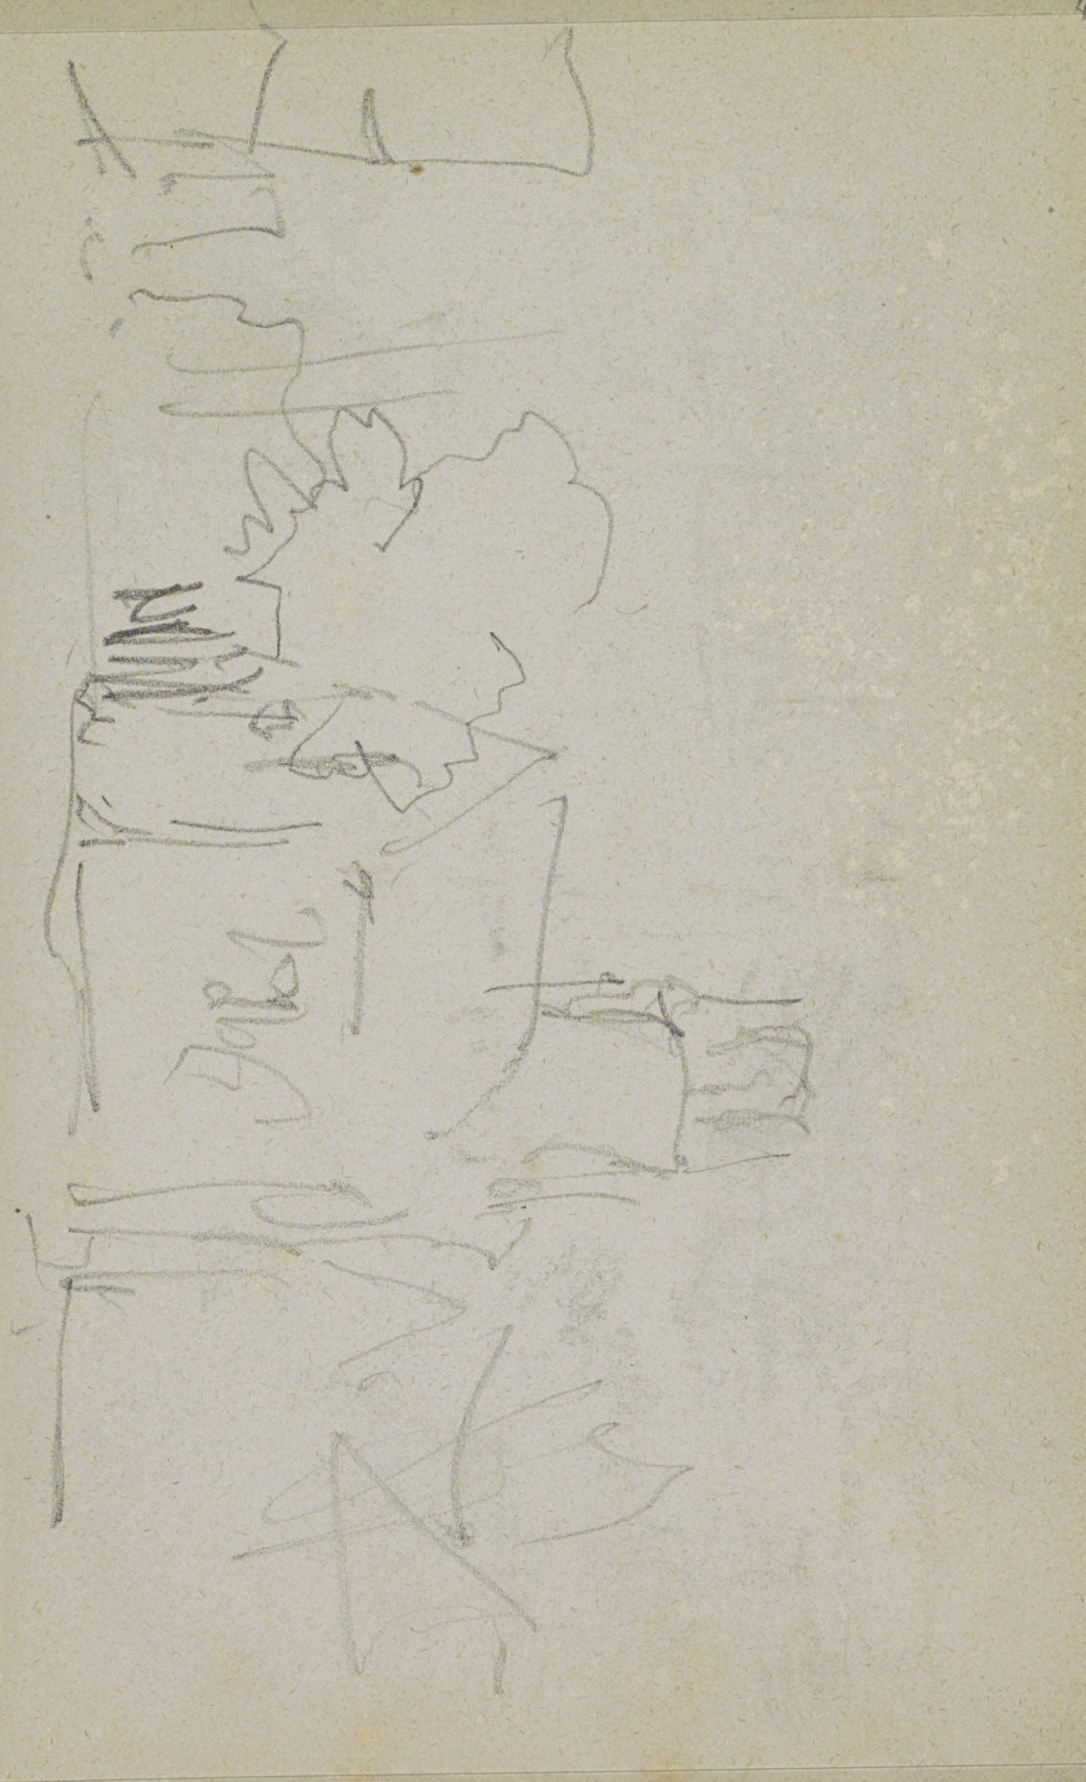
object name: sketchbook leaf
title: Stadsgezicht met een kerk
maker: adrianus eversen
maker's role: draughtsman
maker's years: 1818-1897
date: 1828-1897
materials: paper, pencil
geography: netherlands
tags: city-view, and landscape with man-made constructions, church (exterior)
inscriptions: kleurnotitie, handgeschreven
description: Stadsgezicht met een kerk. Blad 49 recto uit een schetsboek met 58 bladen.